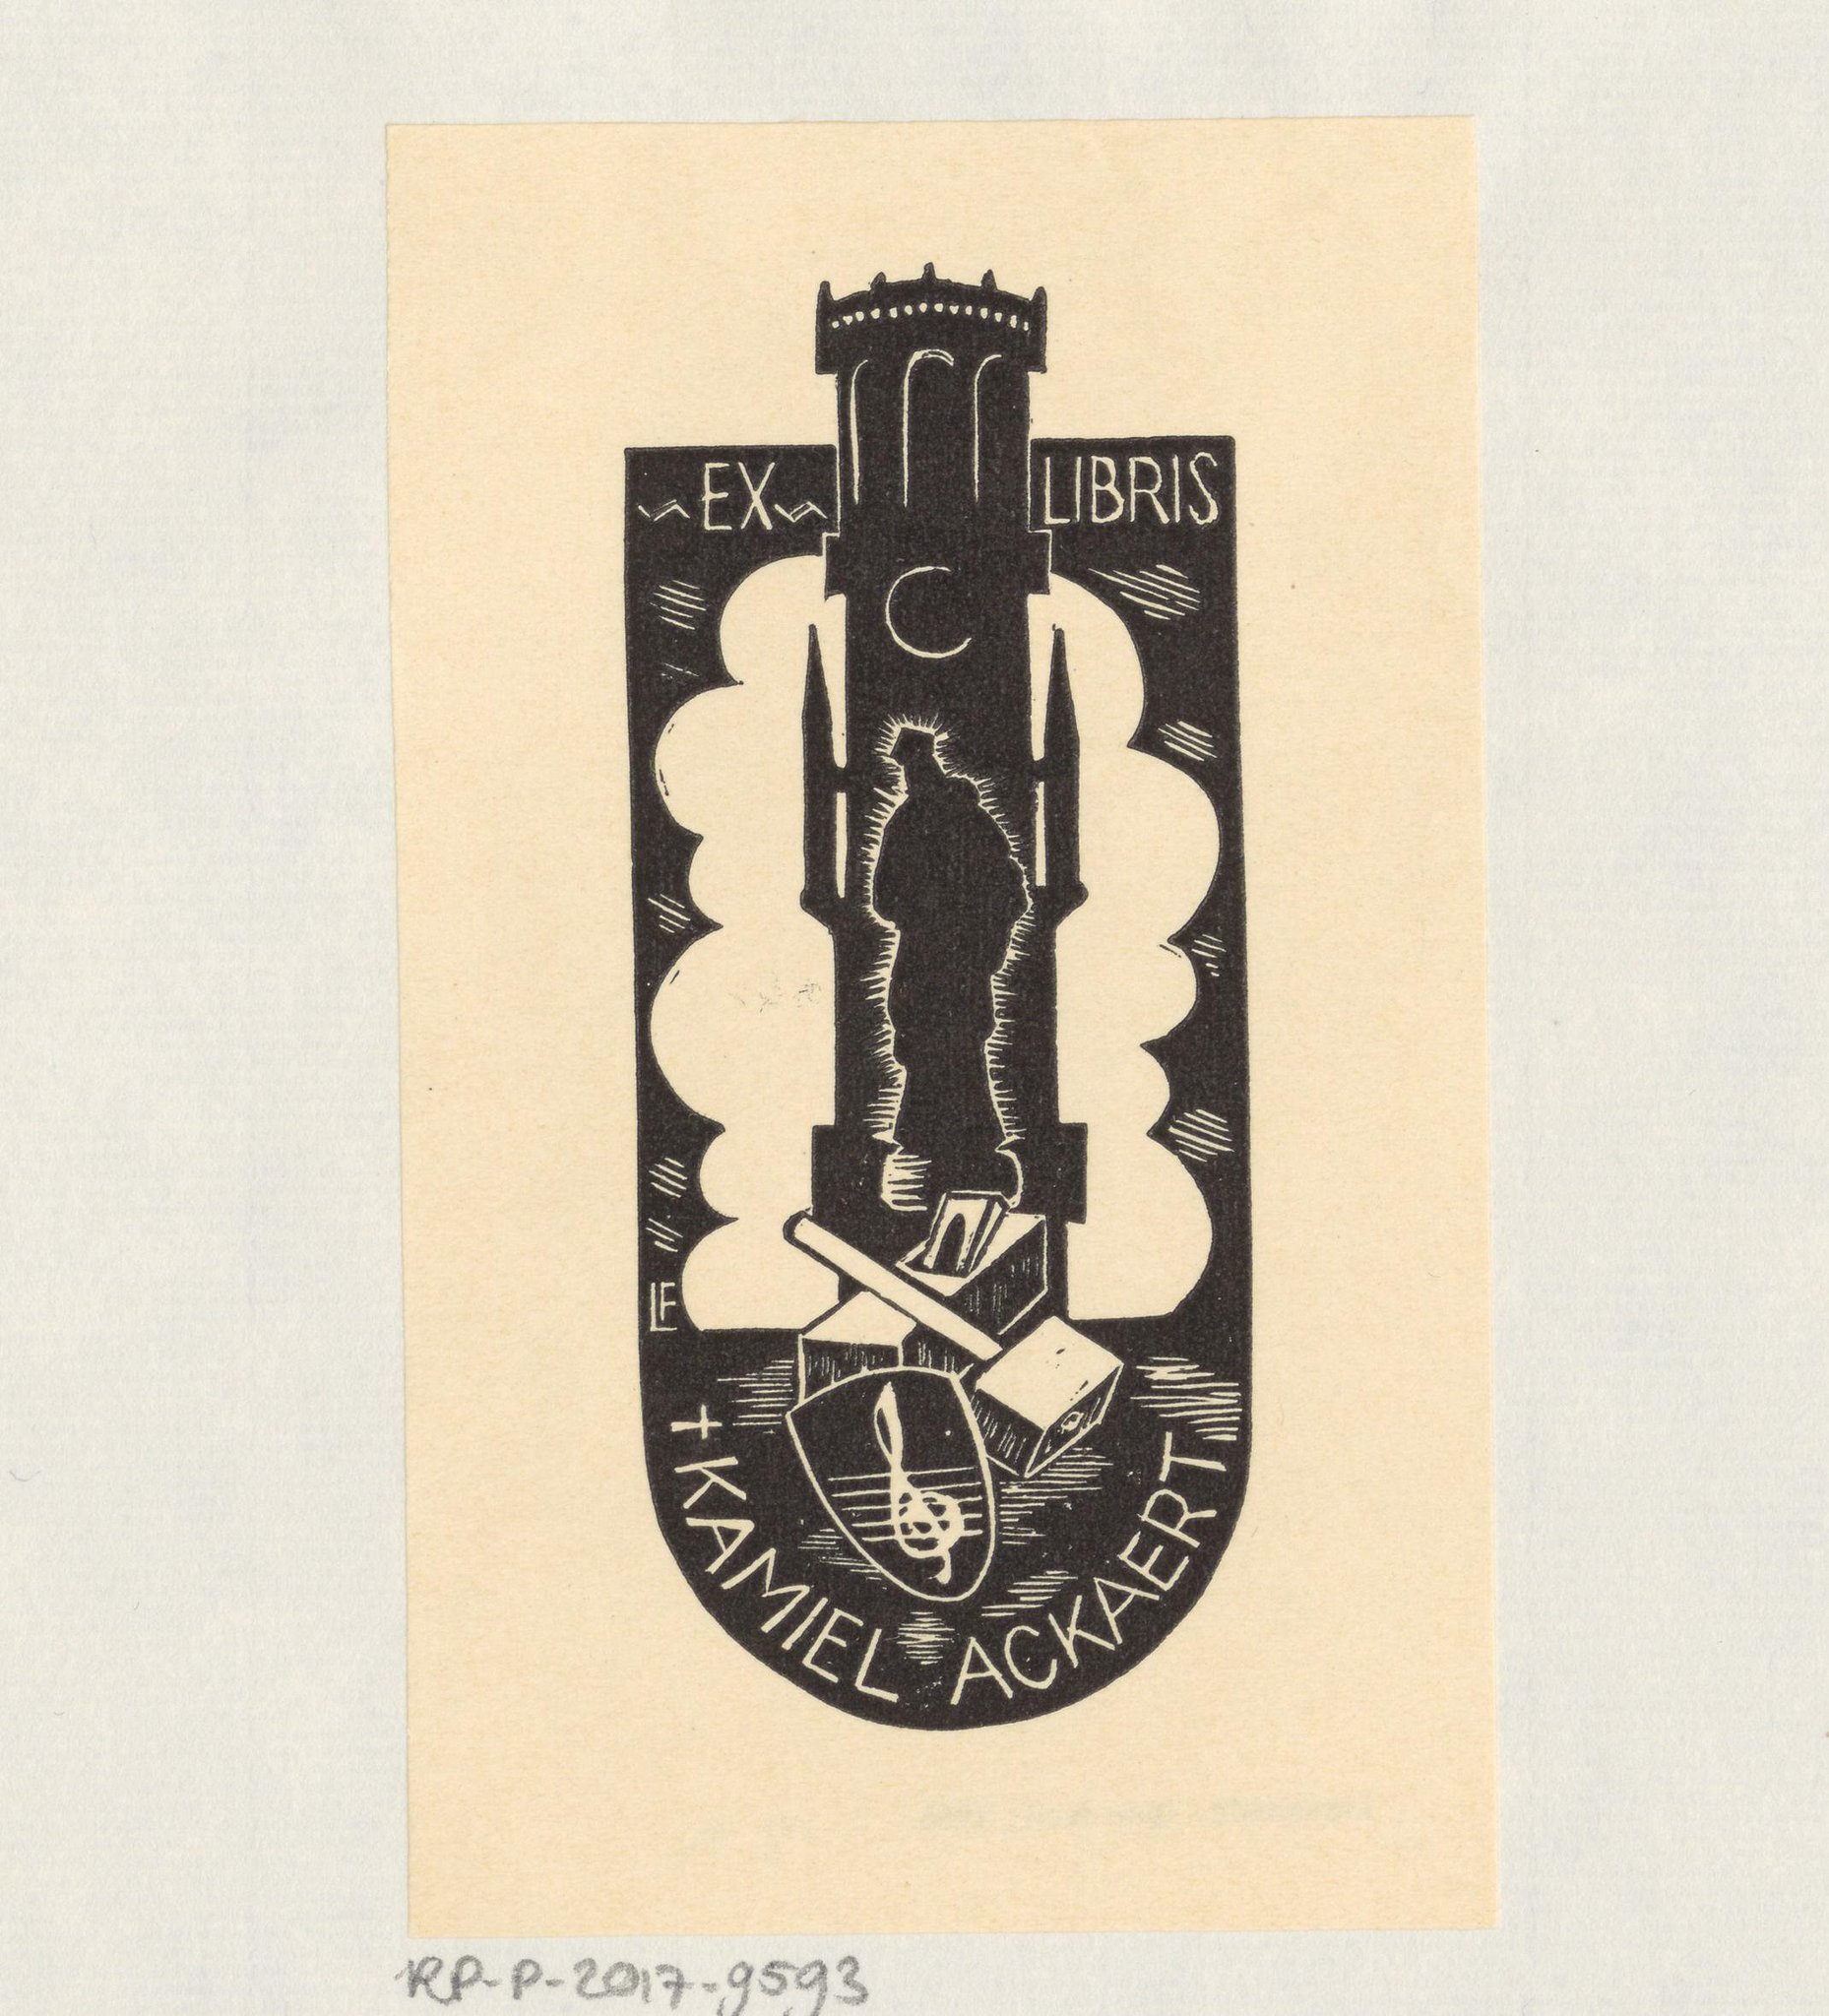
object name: bookplate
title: Ex libris van Kamiel Ackaert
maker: frans lasure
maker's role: print maker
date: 1955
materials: paper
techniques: linocut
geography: belgium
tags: bruges, parts of church exterior and annexes: campanile, notation of music, tools, aids, implements ~ crafts and industries: plane, saints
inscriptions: inscription: ‘Linolsnede: ipse fecit; 1955’